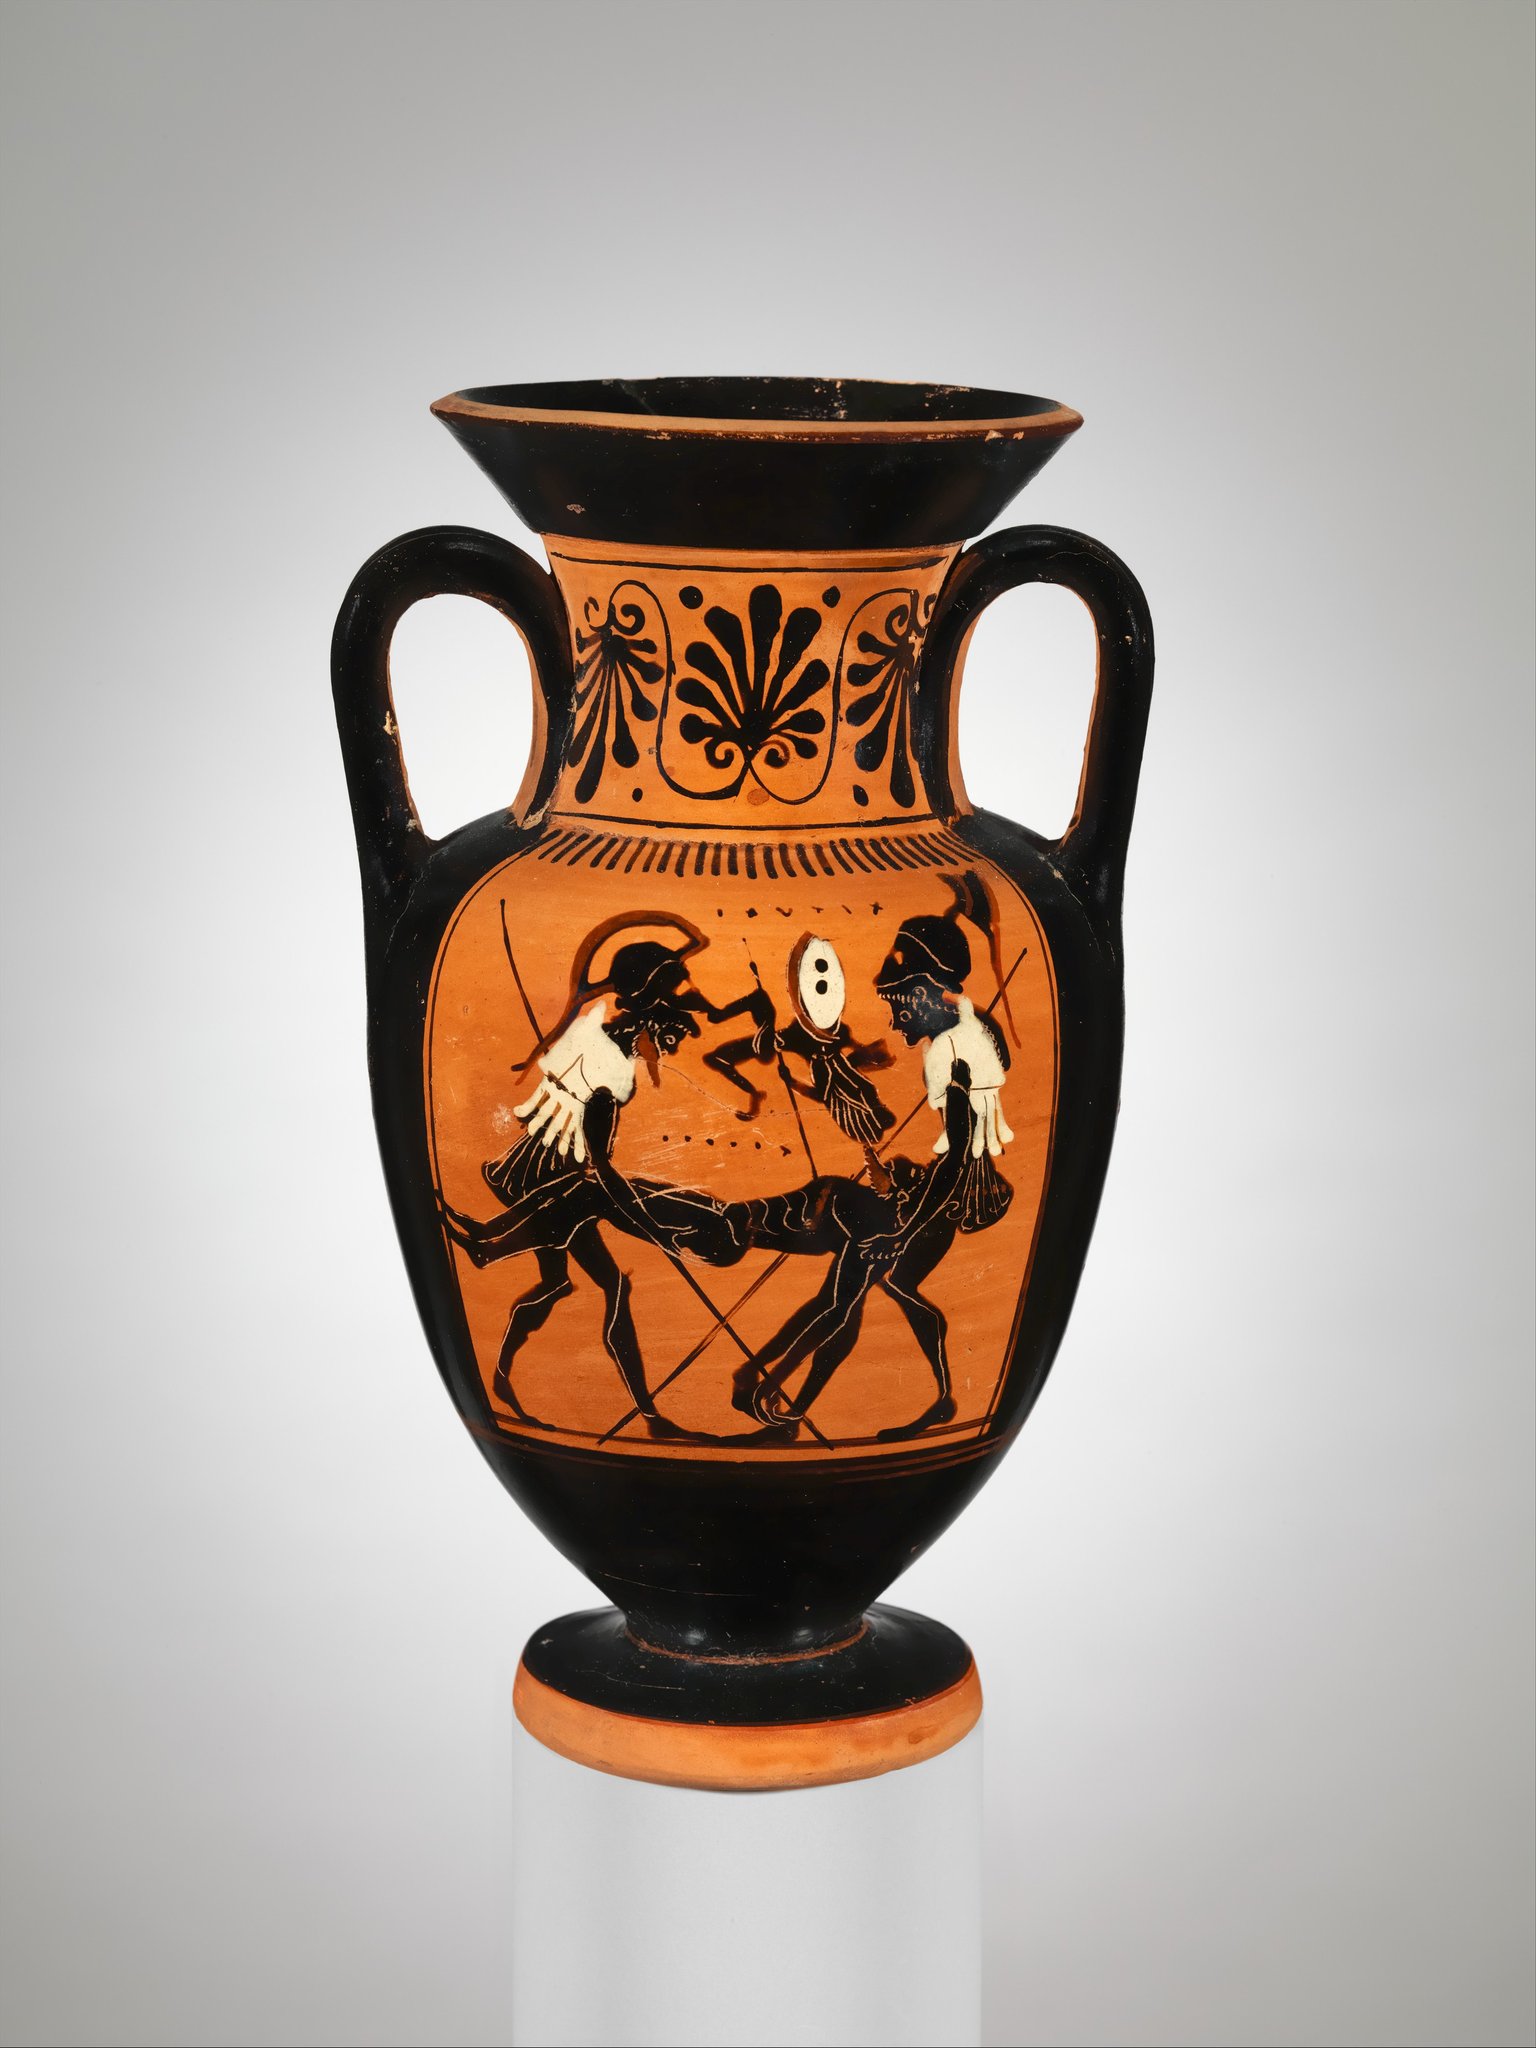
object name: neck amphora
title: Terracotta neck-amphora (jar)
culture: greek, attic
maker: diosphos painter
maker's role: artist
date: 500 BCE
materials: terracotta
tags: men,death,eos